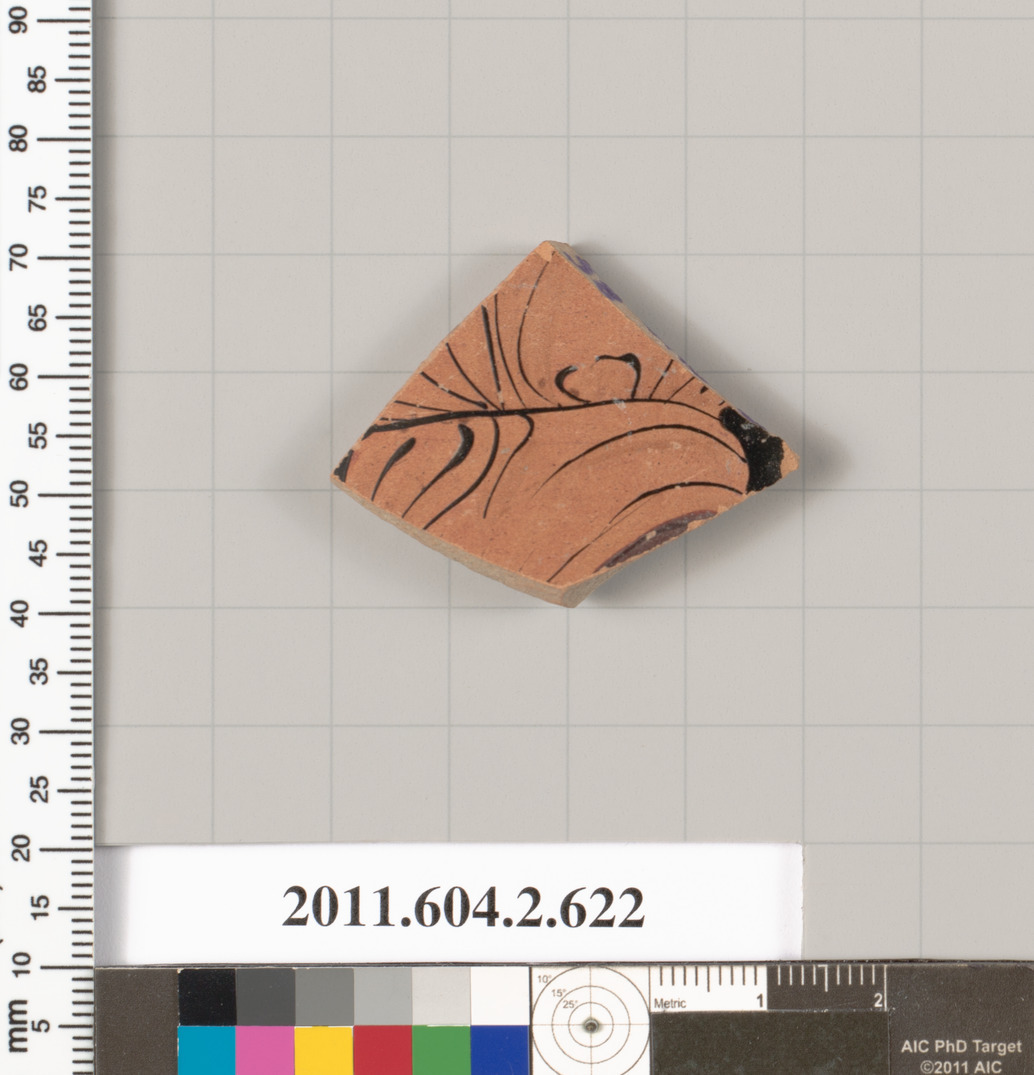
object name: column krater fragment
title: Terracotta fragment of a column-krater (bowl for mixing wine and water)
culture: greek, attic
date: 460-440 BCE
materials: terracotta